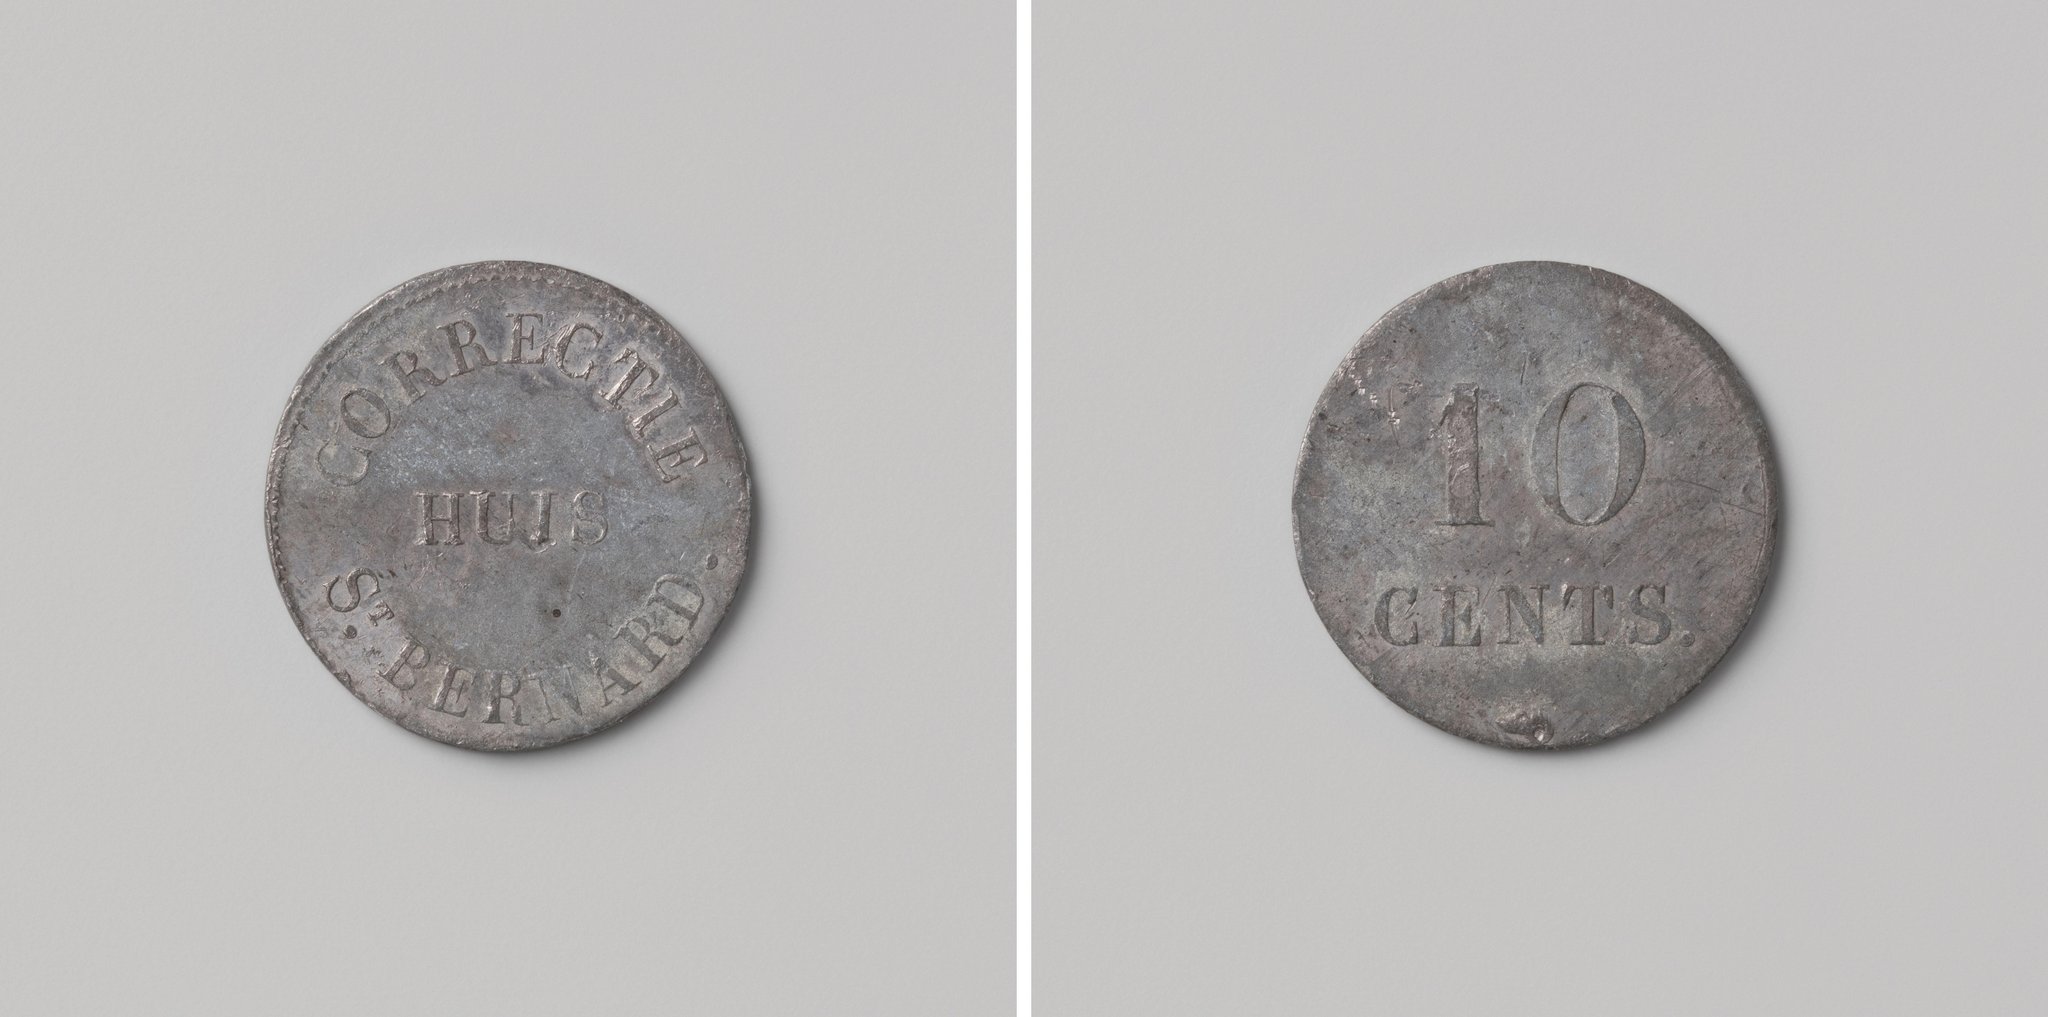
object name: tien cent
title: Correctiehuis Sint Bernhard te Hemiksem, huismunt ter waarde van tien cents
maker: joseph pierre braemt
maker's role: print maker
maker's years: 1796-1864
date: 1826-1833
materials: zinc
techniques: striking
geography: brussels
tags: ghent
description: Zinken betaalpenning. Voorzijde: opschrift binnen omschrift. Keerzijde: waardeaanduiding